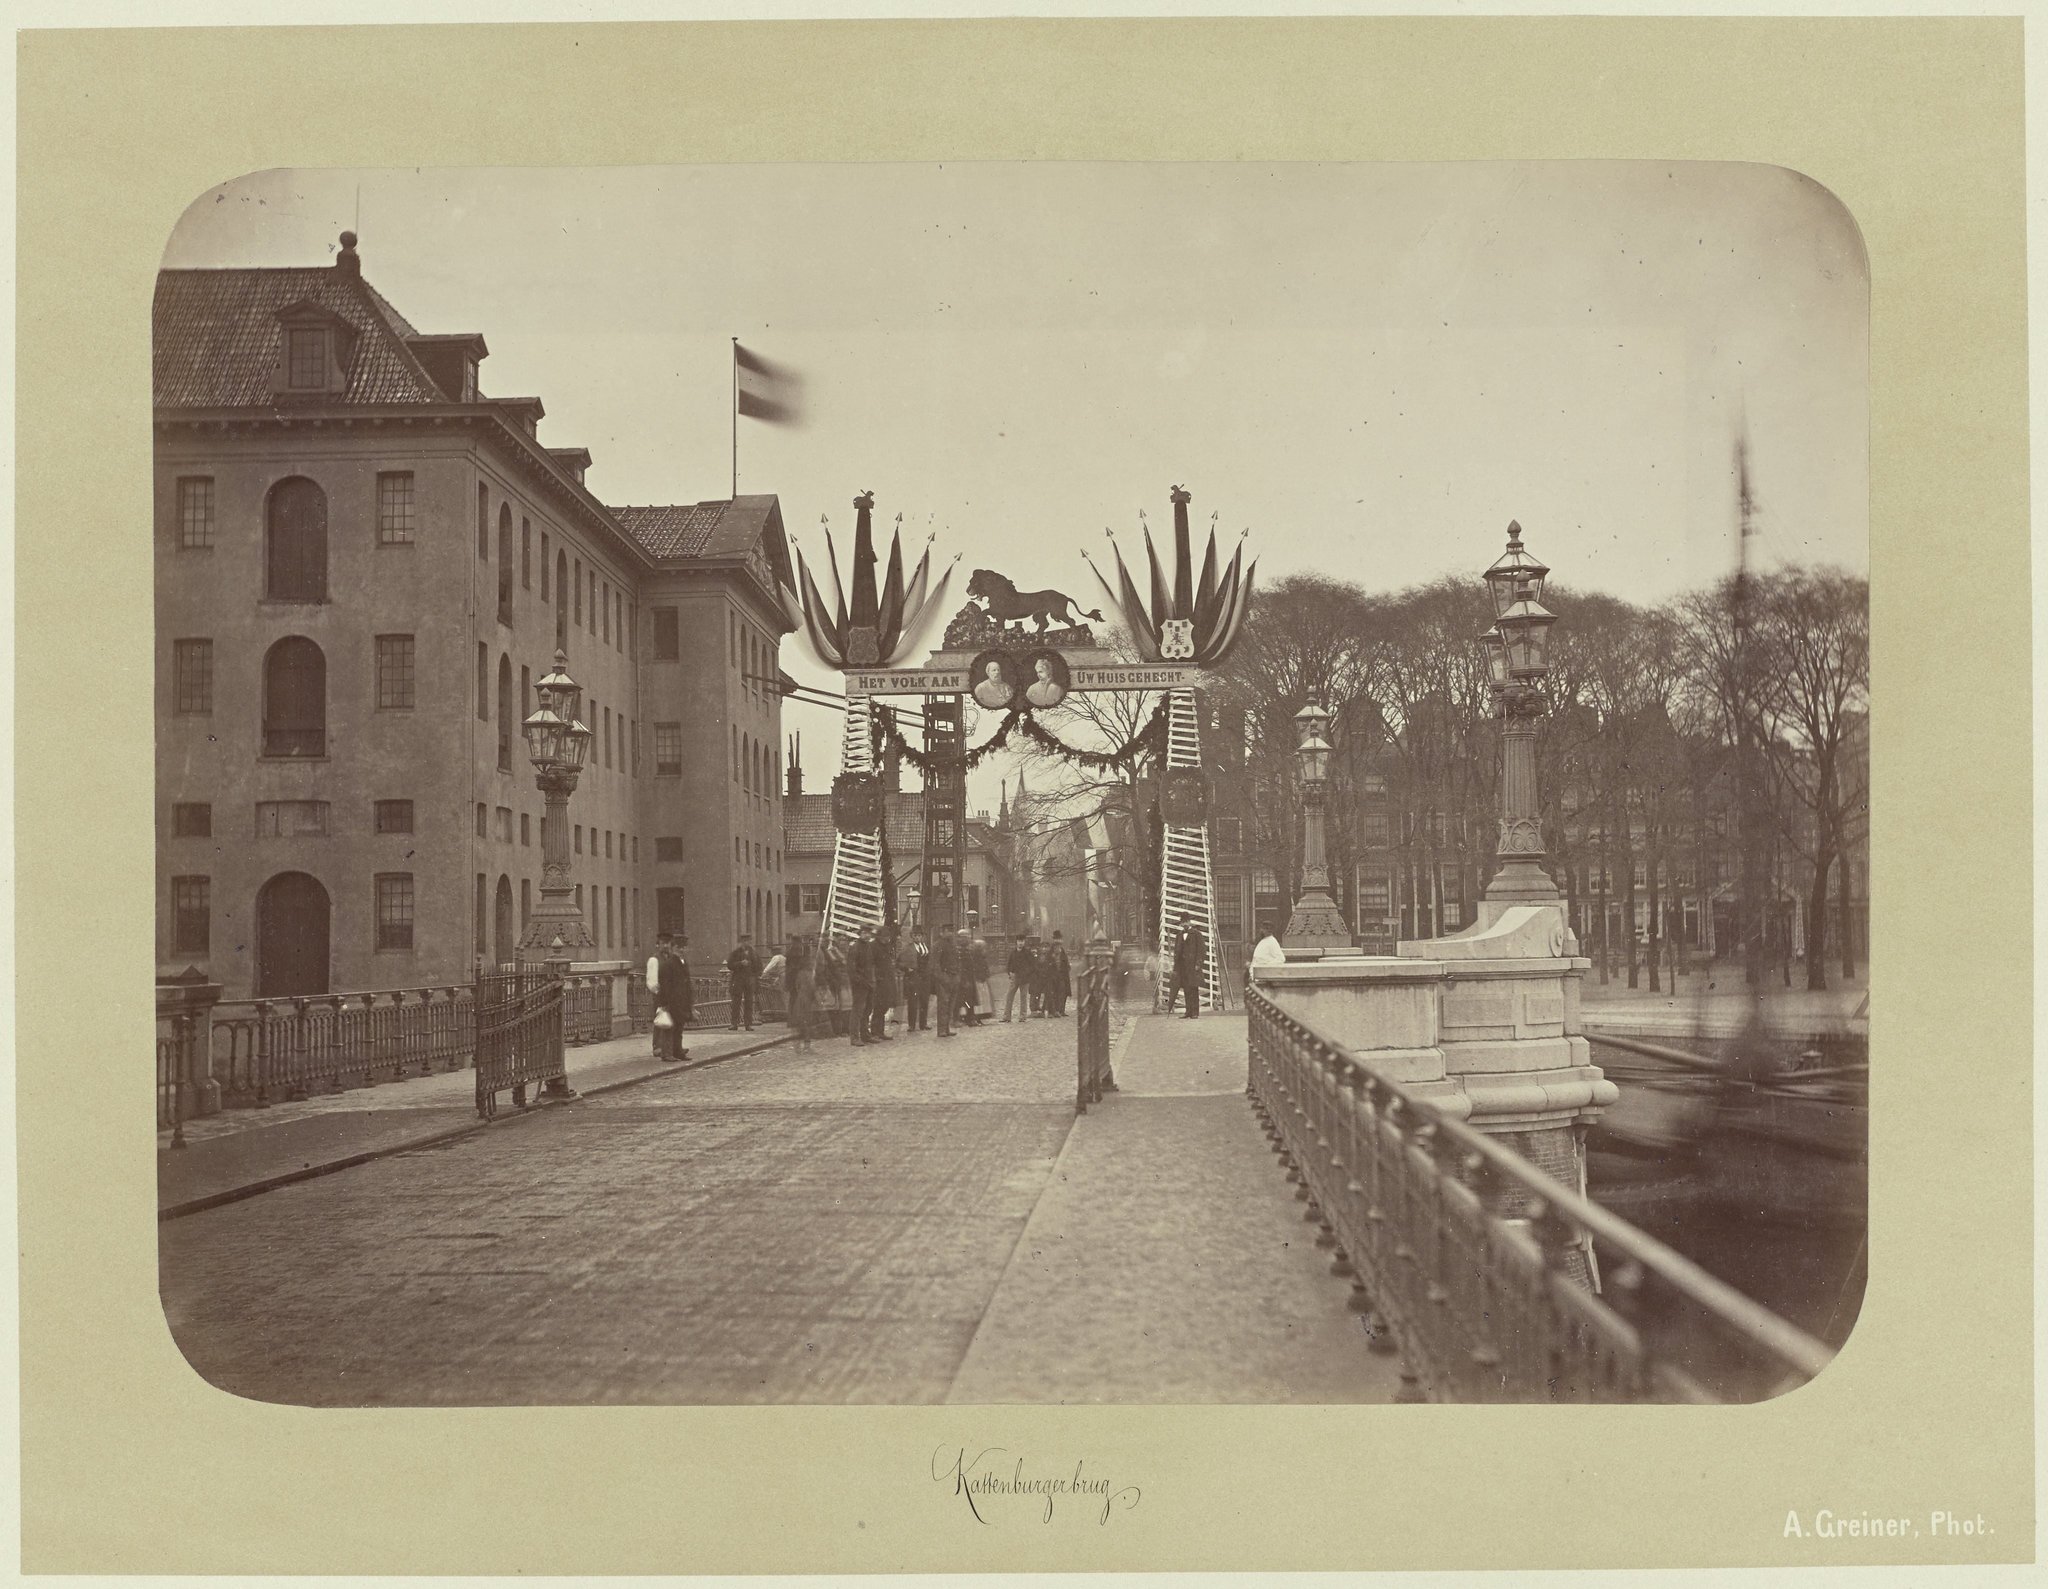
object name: photograph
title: De Kattenburgerbrug, 1879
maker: albert greiner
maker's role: fotograaf, fotostudio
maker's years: 1833-1890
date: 1879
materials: cardboard, paper, photographic support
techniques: albumen print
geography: amsterdam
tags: the hague, emma (queen consort of the netherlands), brussels, willem iii (koning der nederlanden), visiting; receiving guests; elegant company, landscape with bridge, viaduct or aqueduct, decorations, honours (as symbols of the state, etc.)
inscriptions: inscription: ‘Kattenburgerbrug.’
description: Decoraties aangebracht op de Kattenburgerbrug. Bij de brug staat een groep mannen. Links het Zeemagazijn. Onderdeel van een serie van tien foto's van de versieringen aangebracht in de stad ter gelegenheid van het bezoek van koning Willem III en zijn tweede echtgenote Emma aan Amsterdam op 21 april 1879.